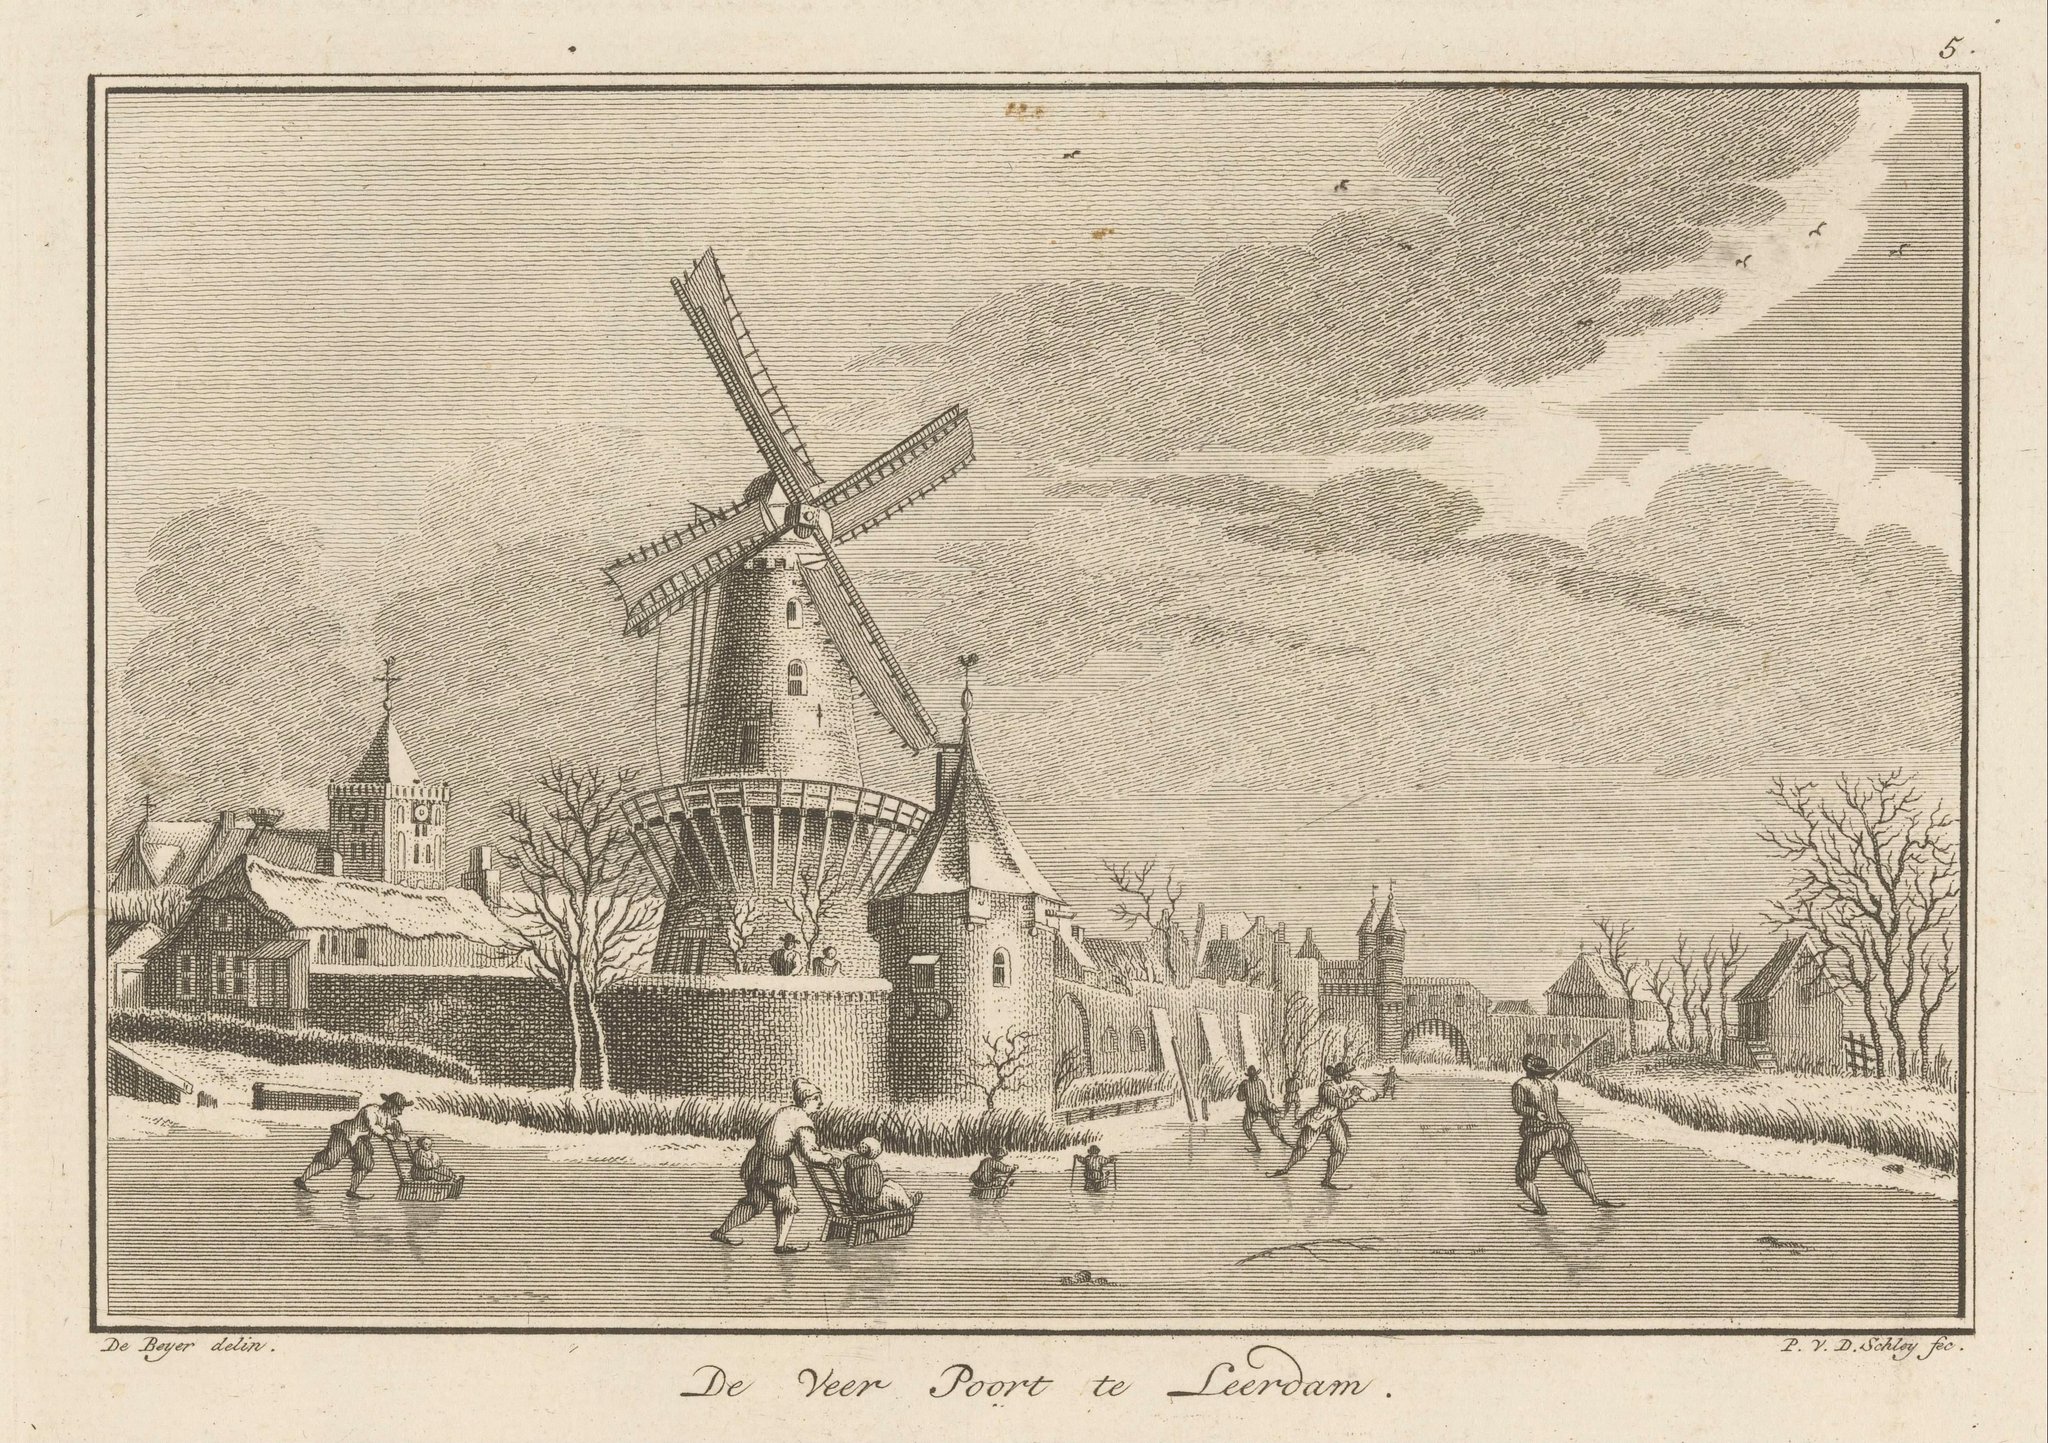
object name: print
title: De Veer Poort te Leerdam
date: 1739-1817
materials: paper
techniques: etching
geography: amsterdam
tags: winter sports, church (exterior), skates (winter sports), windmill, city-gate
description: Schaatsers en mensen met sleetjes vermaken zich op het ijs buiten de stadmuren van Leerdam. Op de achtergrond de Veerpoort. Rechtsboven genummerd: 5.